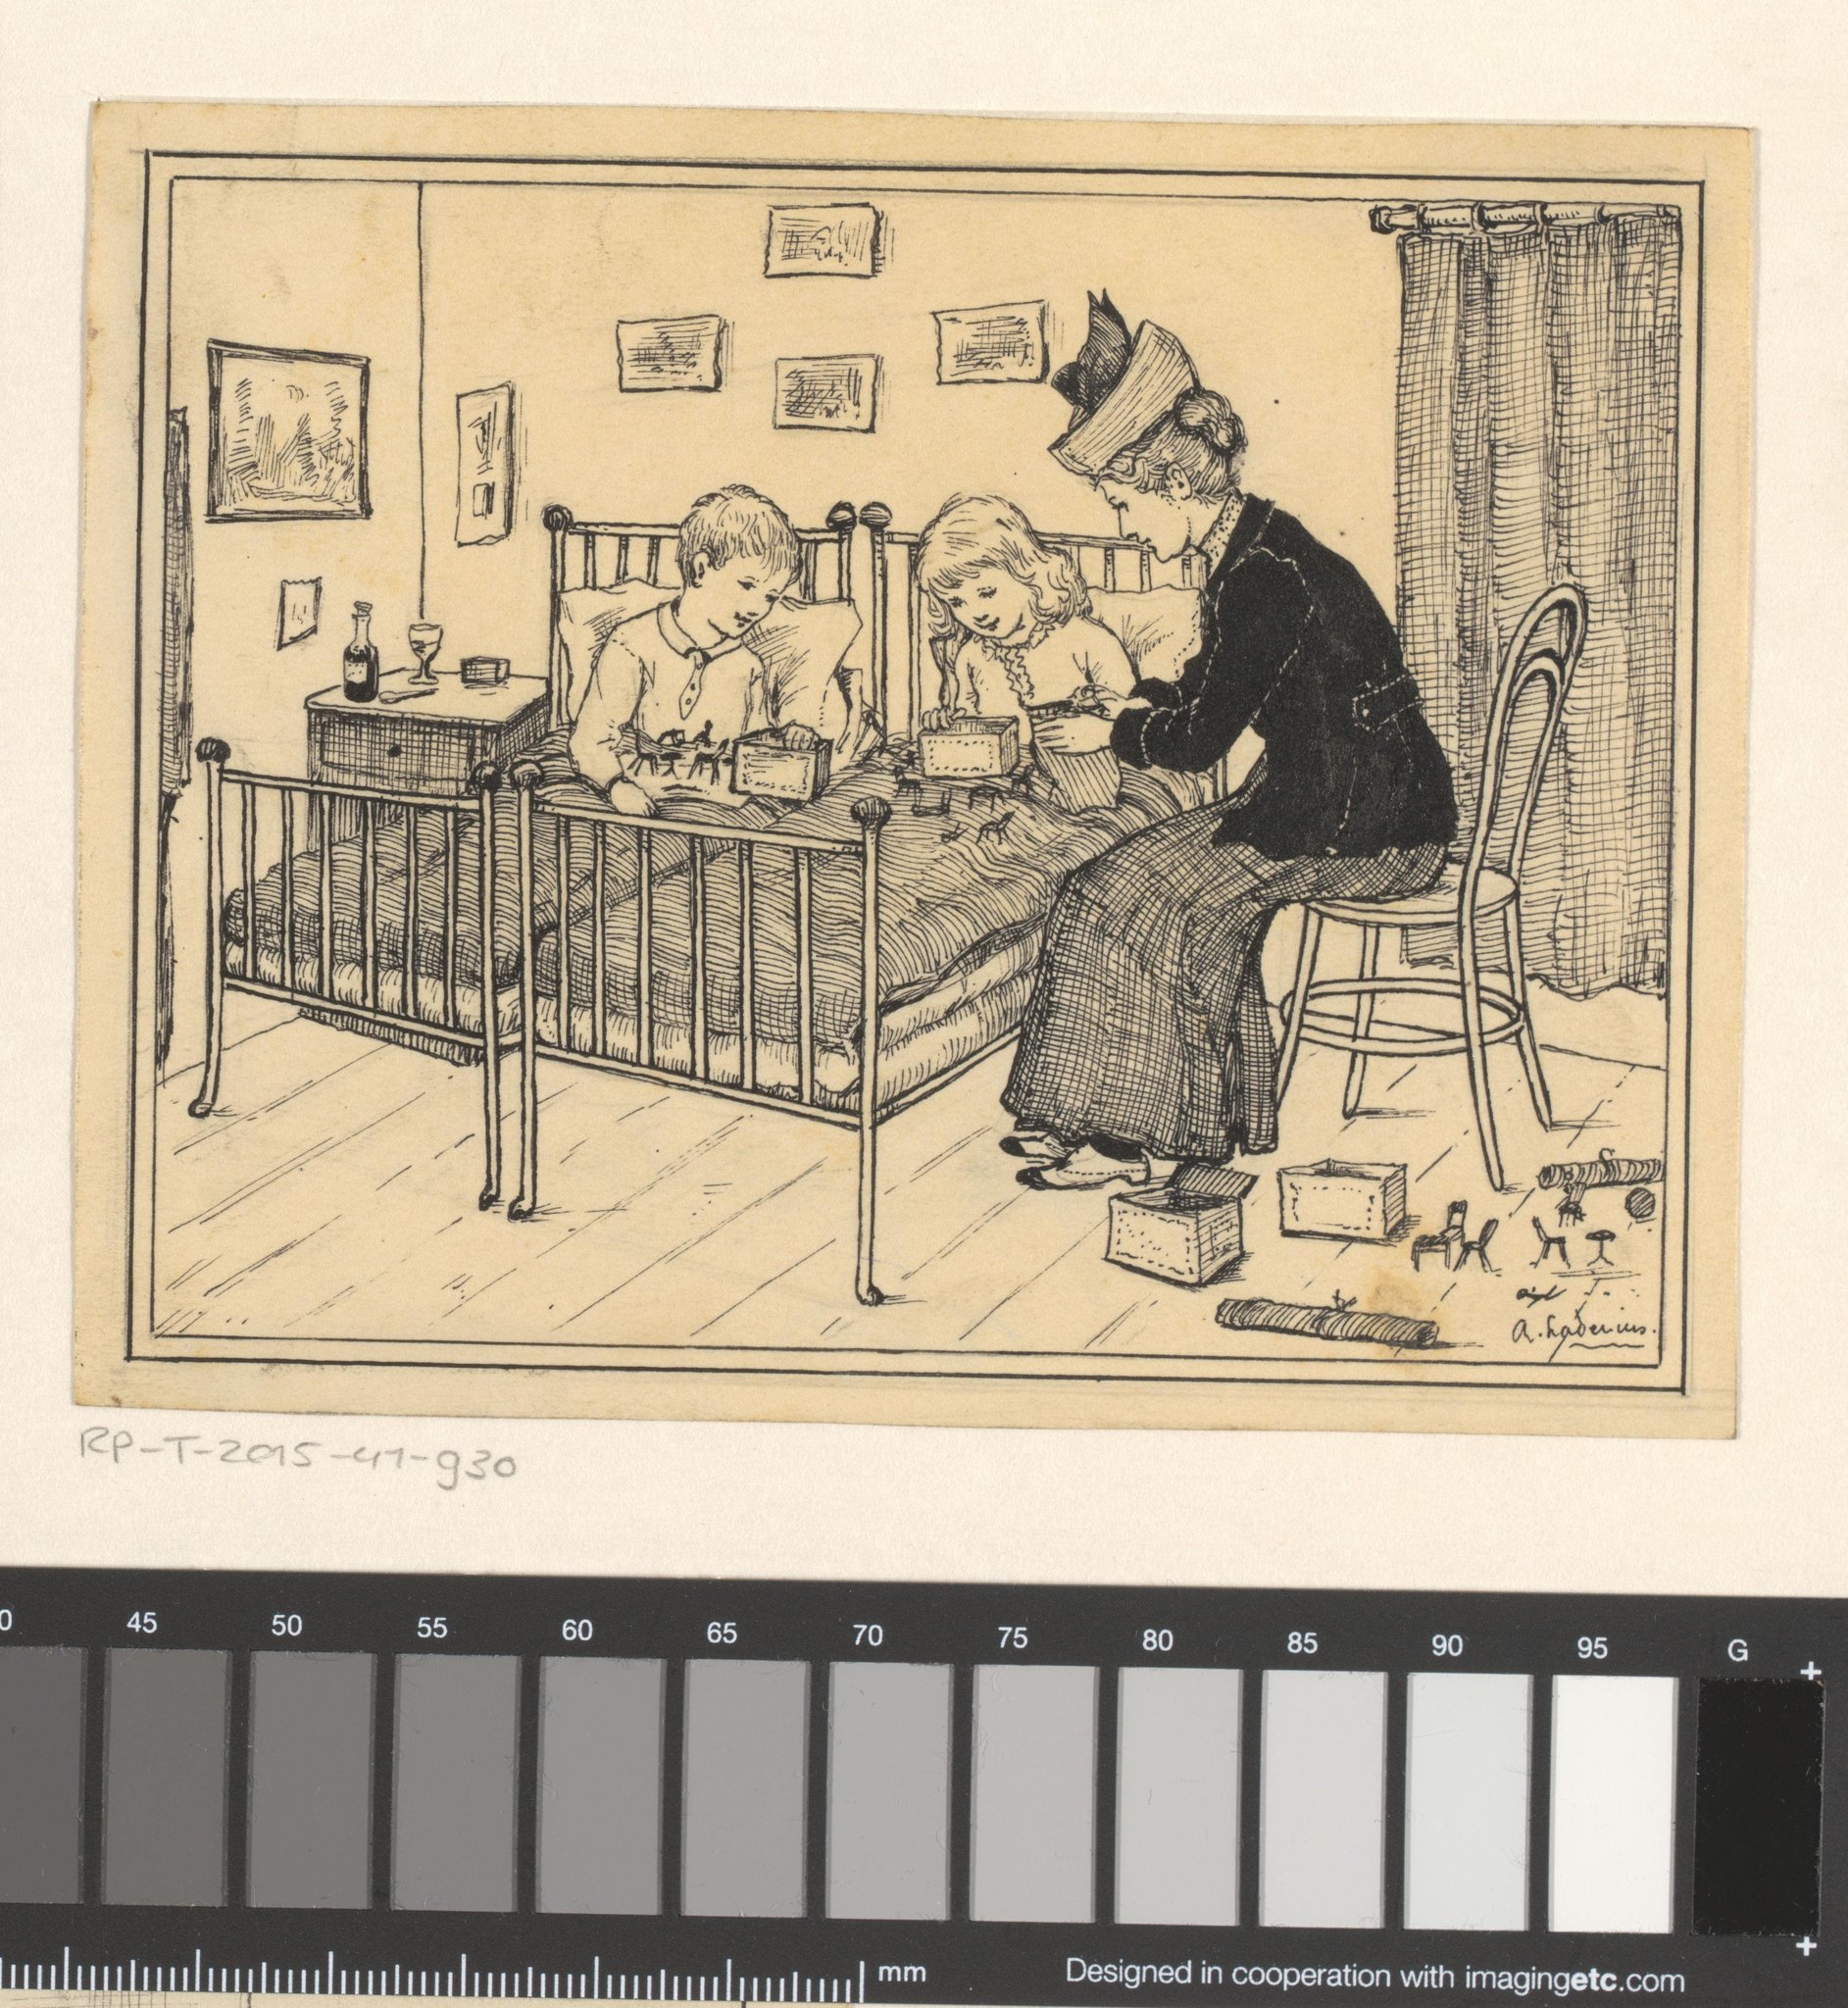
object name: drawing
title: Jongen en meisje met speelgoed op bed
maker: adri ladenius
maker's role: draughtsman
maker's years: 1883-1953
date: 1893-1953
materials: ink, paper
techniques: pen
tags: boy (child between toddler and youth), spirit of the earth, gnome, troll, bed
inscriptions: collector's mark: Lugt 2228, :, signature: ‘A. Ladenius’, annotation: ‘wat Me[...] Kees/ maakte’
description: In een kinderkamer zitten een jongen en meisje rechtop in twee tegen elkaar geschoven ledikanten. Ze spelen met speelgoed dat op de dekbedden ligt. Een vrouw zit aan het bed van het meisje en reikt naar een doos die op haar schoot staat.